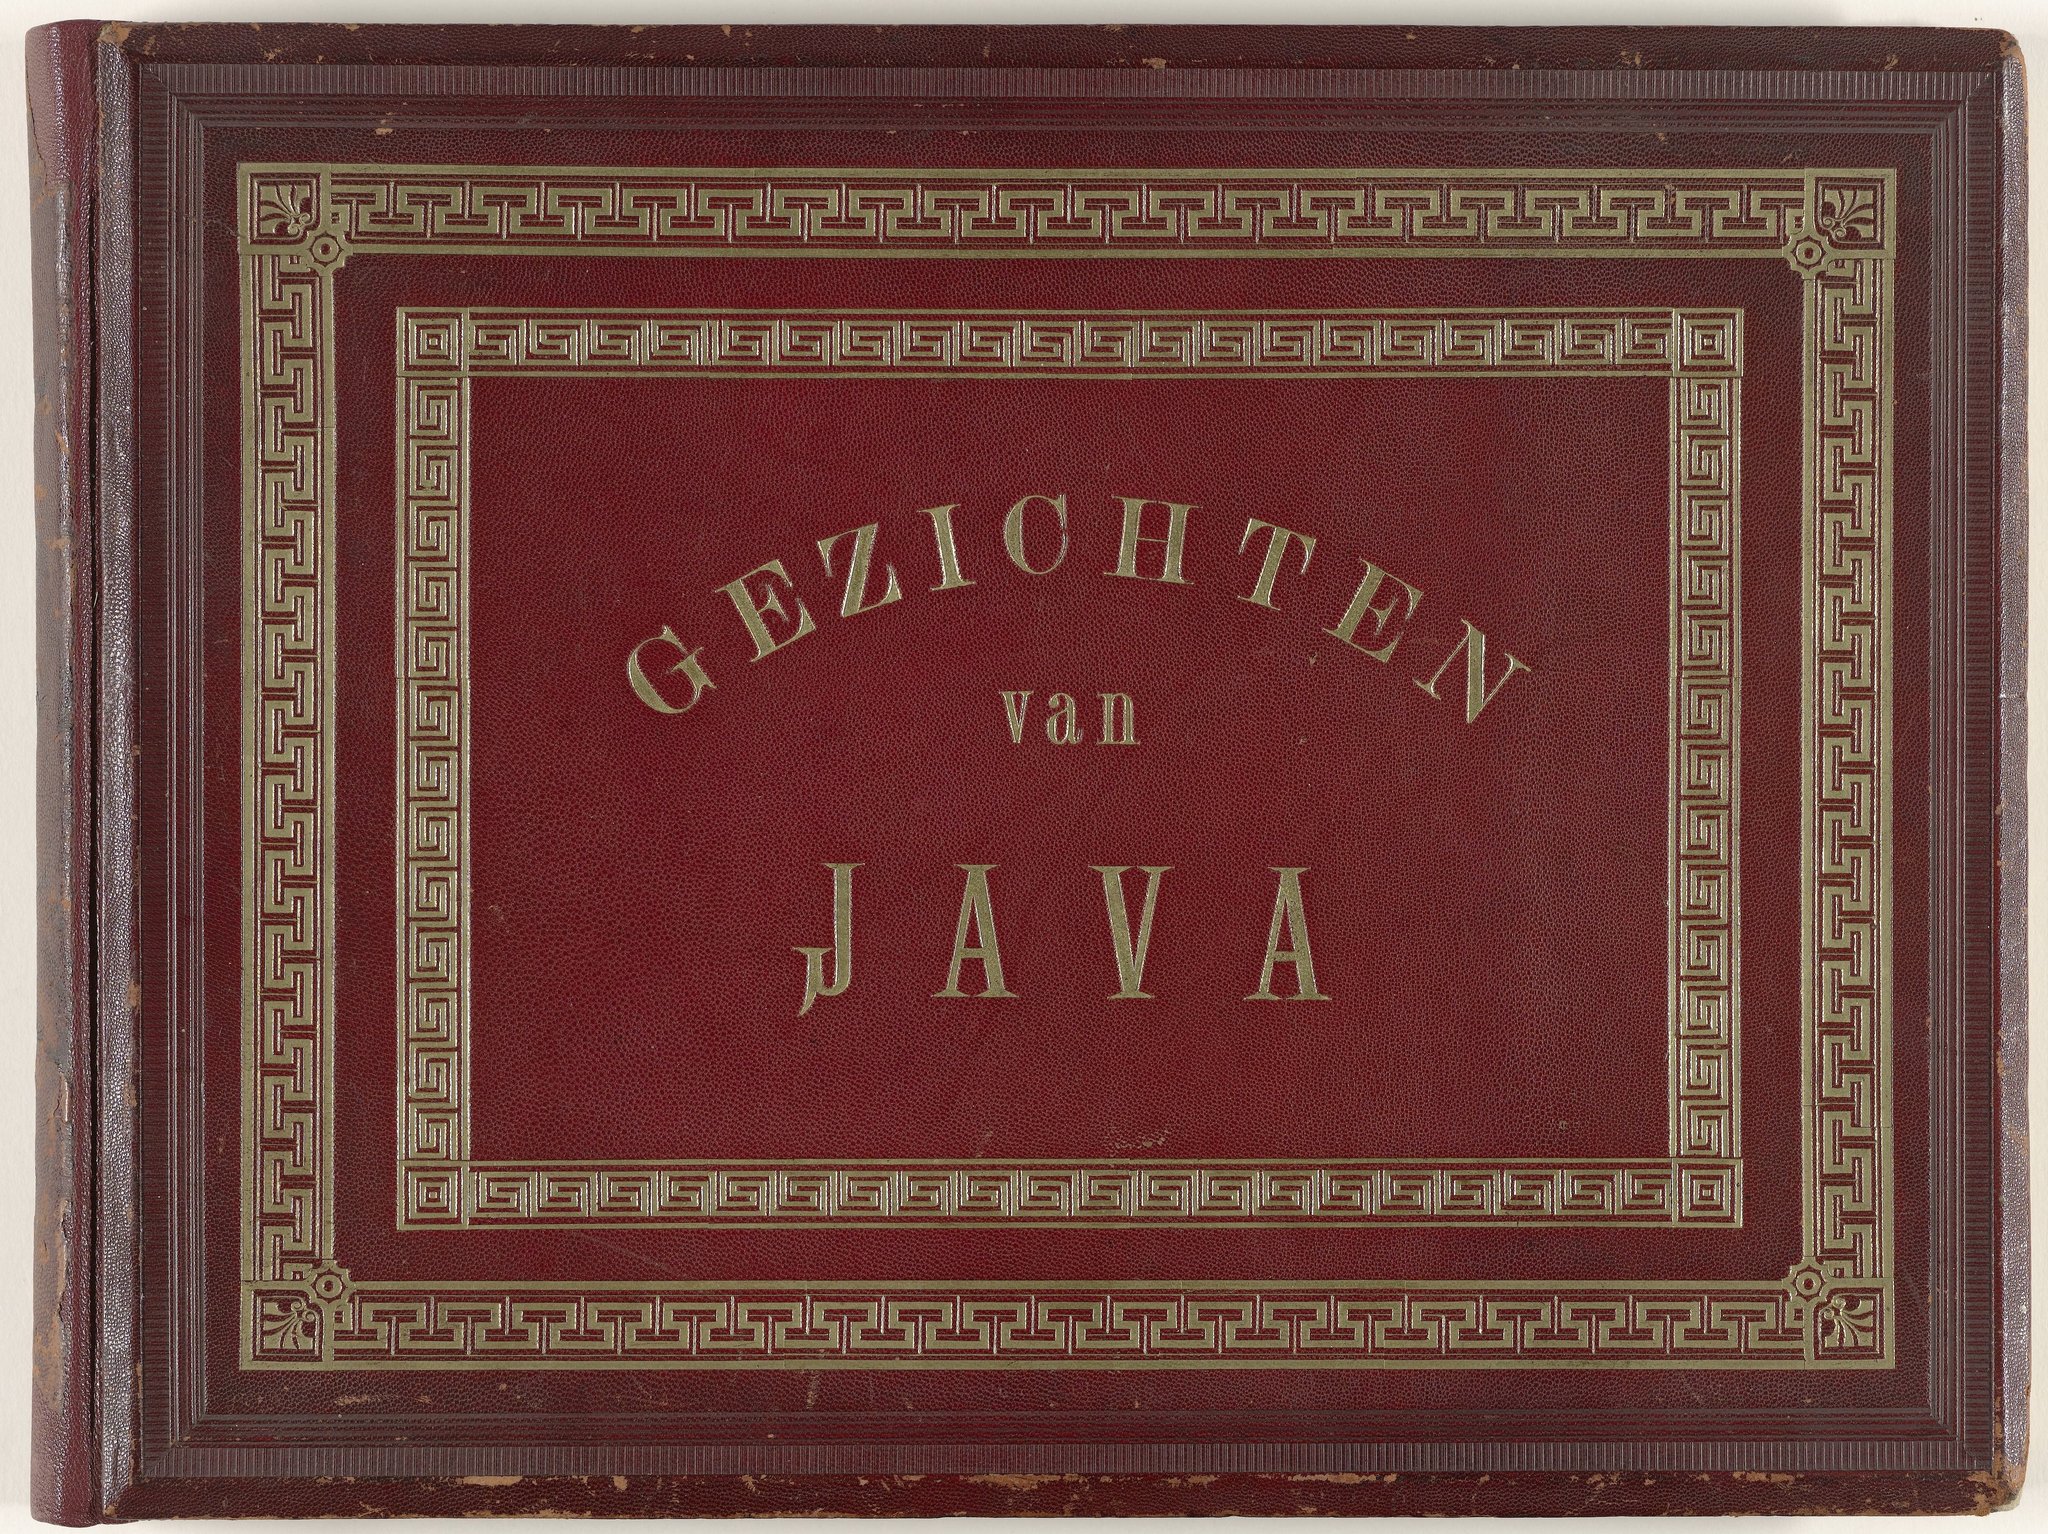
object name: photograph album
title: Gezichten van Java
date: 1865-1890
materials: leather, paper, photographic support, textile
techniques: albumen print, bookbinding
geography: batavia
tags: java, batavia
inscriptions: inscription: ‘Gezichten van Java’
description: Album met roodleren band, gladde rug en ingeperste versieringen op voor- en achterzijde. Rechthoekig bandversiering met geometrische figuren; versieringen en opschrift 'Gezichten van Java' op voorzijde ingeperst in goud. Voor- en achterin schutbladen van wit glanzend papier met horizontale golfstructuur. Het album bevat 25 dikke witte bladen, goud op snee, met in totaal 75 foto's. Elk blad heeft op de voorzijde een grote foto en op de keerzijde 2 kleine foto's. Afbeeldingen op de grote foto's: gebouwen, straatgezichten, watergezichten (aan kade enz.) en landschappen te Java en vooral in en rondom Batavia. Op de keerzijde van de bladen zijn kleine foto's geplakt met portretten van Javaanse vorsten en mensen die wonen en werken op Java, alleen of in groepjes, in traditionele dracht. Ook ambachten als weven en enkele stillevens met fruit en siervoorwerpen.